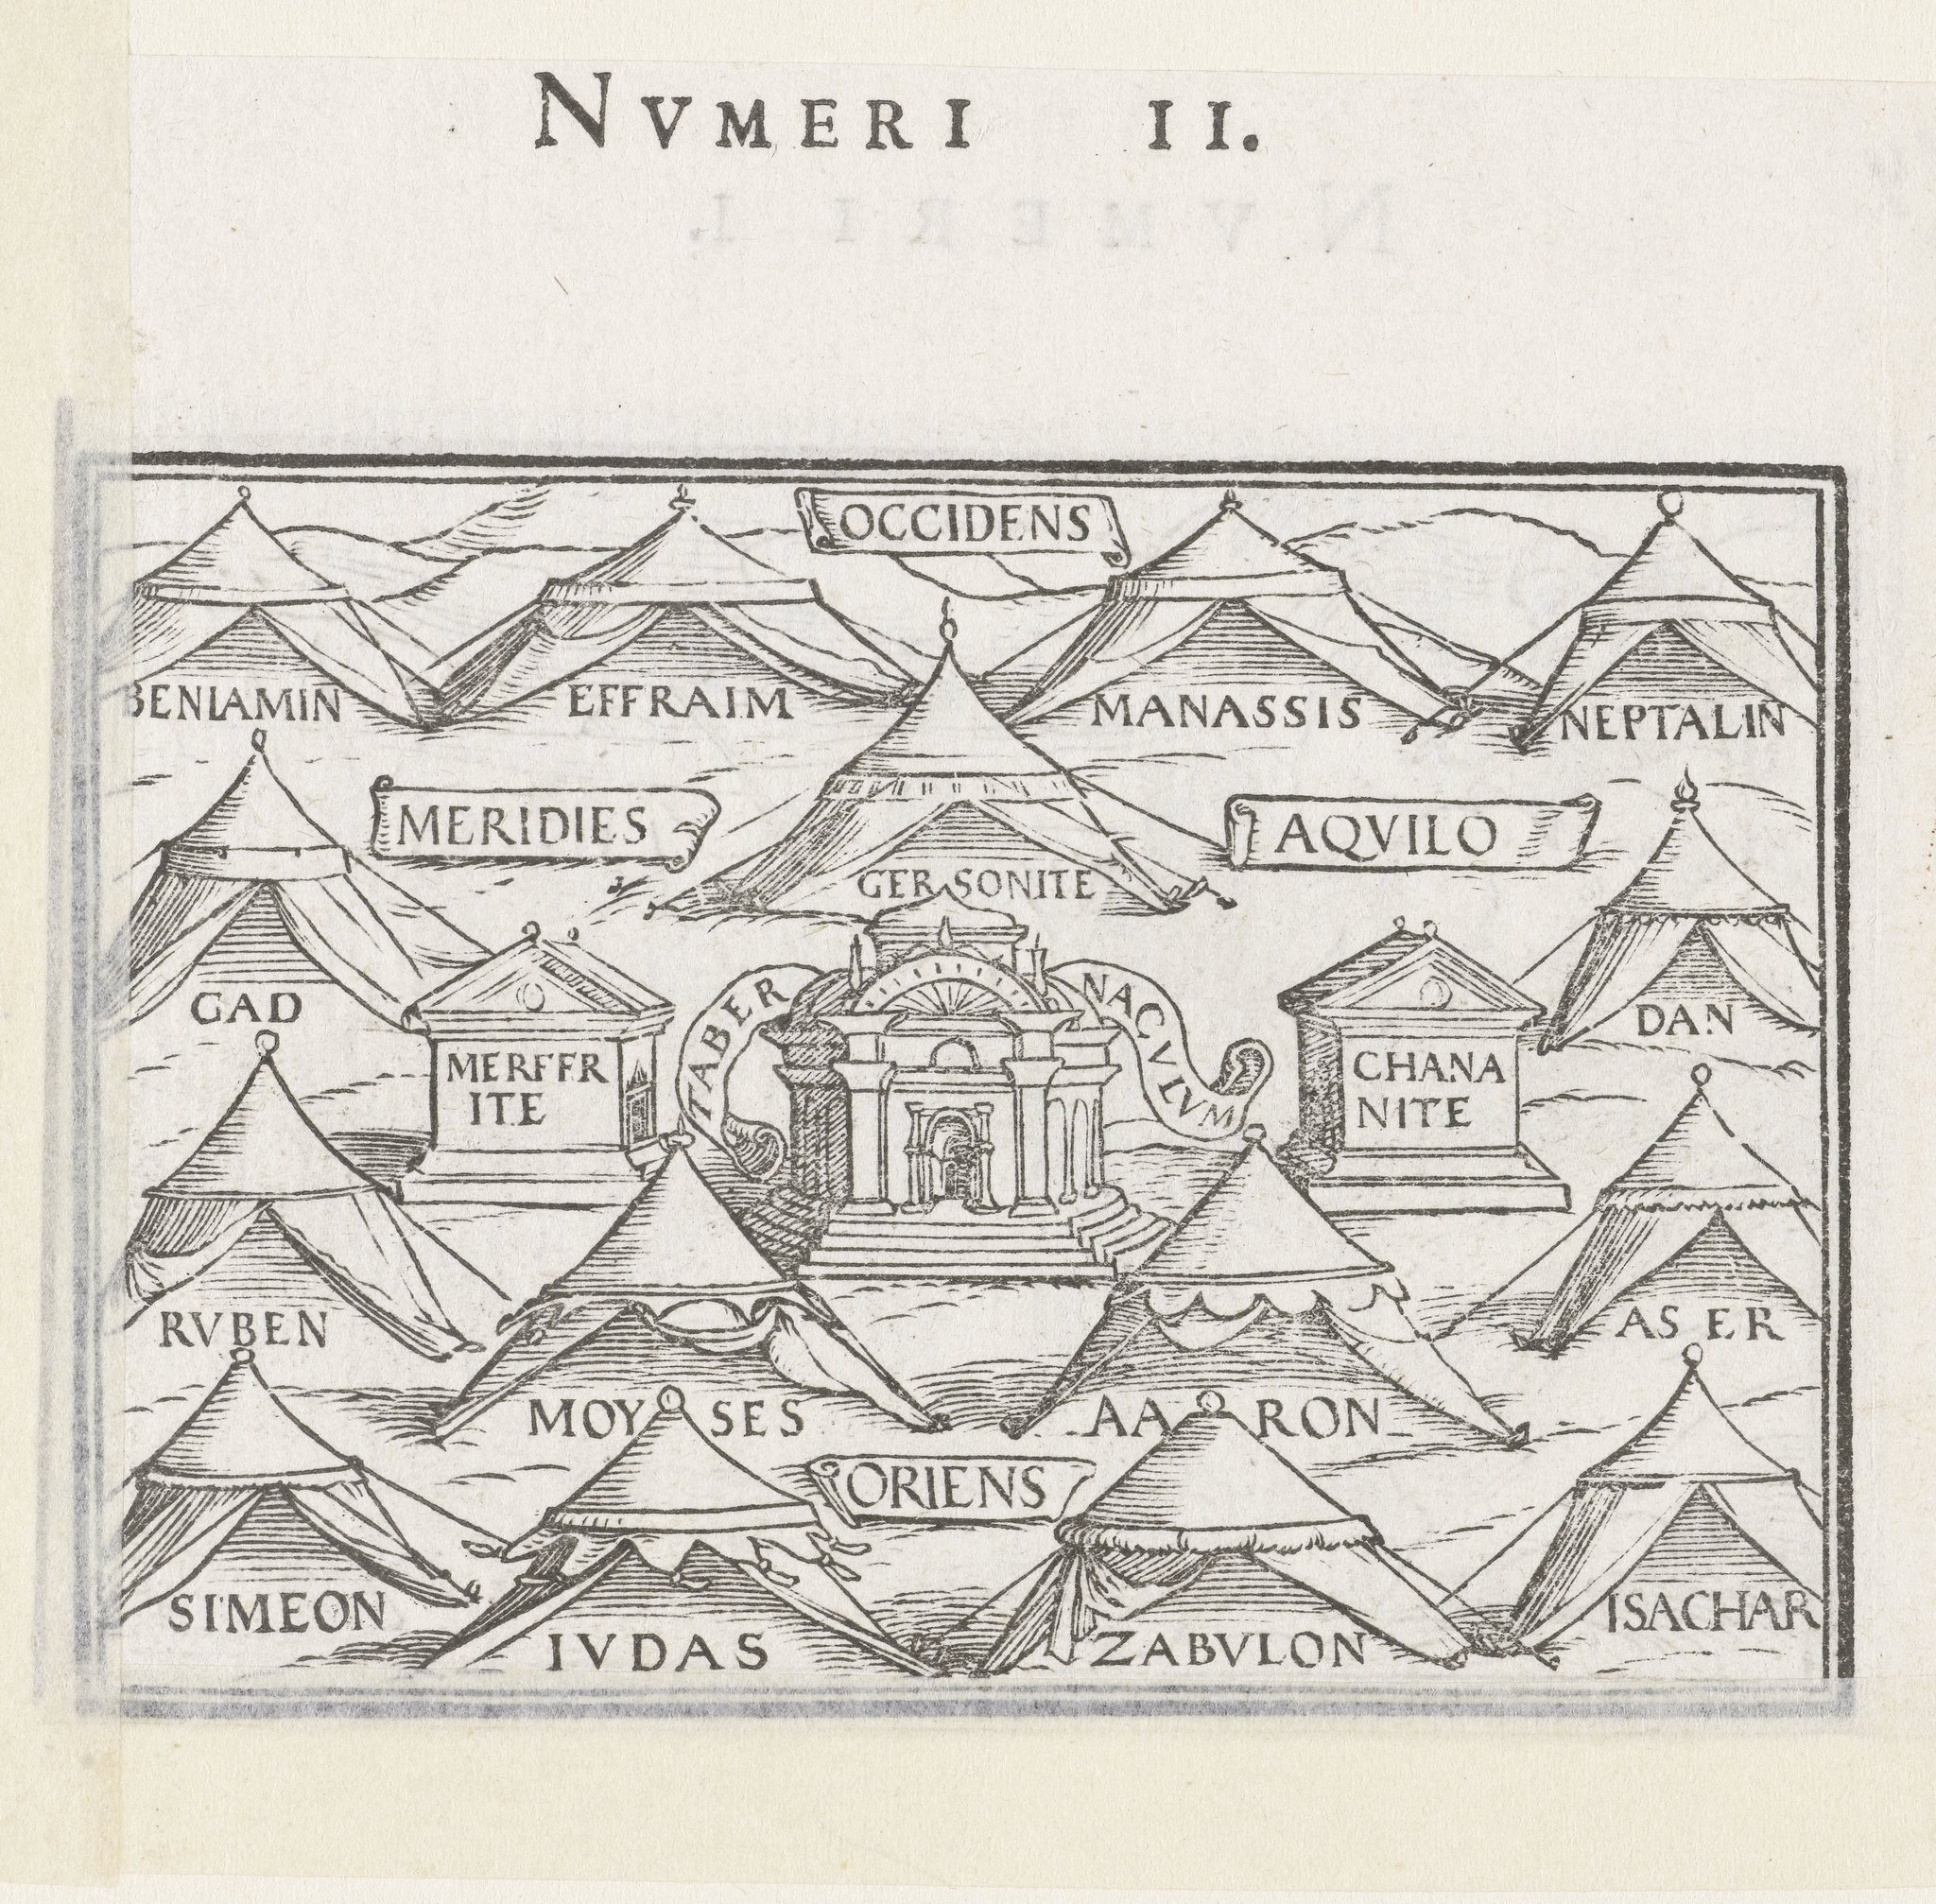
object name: print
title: Tentenkamp van de stammen van Israël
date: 1538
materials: paper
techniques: woodcut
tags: the tribes are arranged in their proper order ~ the book of numbers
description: Tentenkamp van de Israëlieten met in het midden de ontmoetingstent met het tabernakel naar het Oosten gericht zoals op een schildje met tekst bovenaan is aangeduid. Bij de tenten staan de verschillende namen van de stammen van Israël. In de marge boven de afbeelding staat de tekst Nvmeri II.